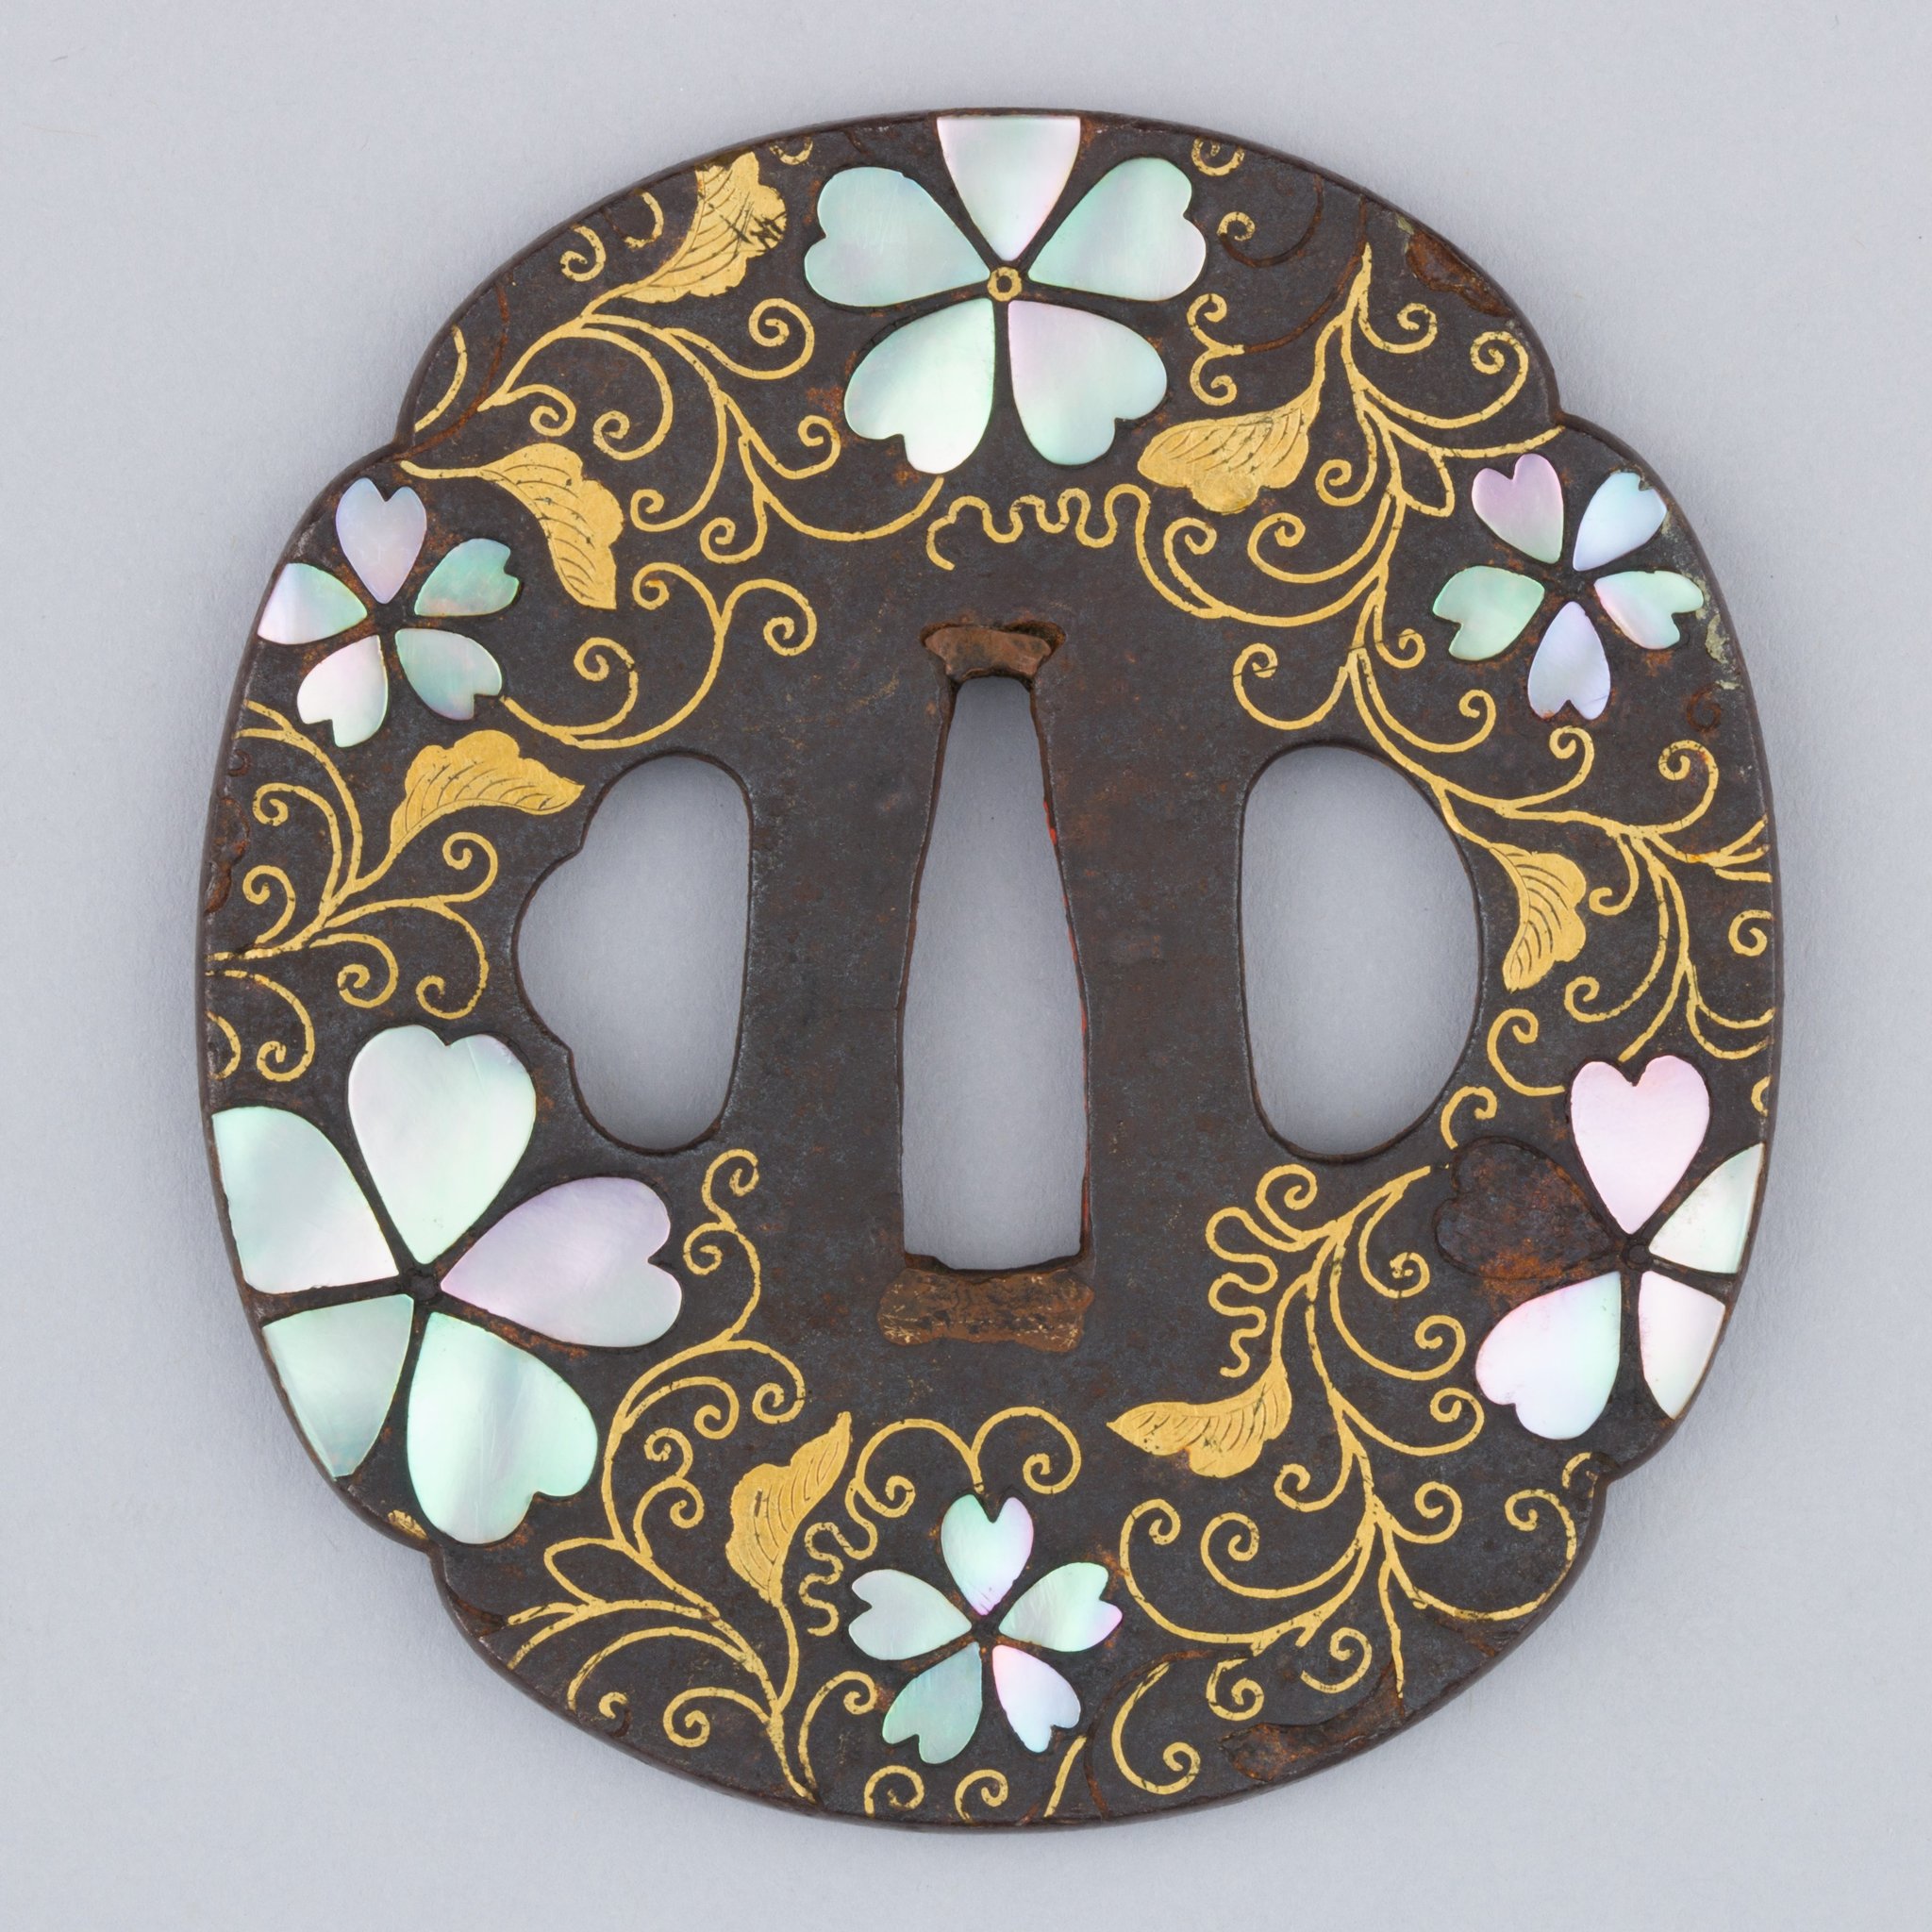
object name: sword guard tsuba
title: Sword Guard (Tsuba)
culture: japanese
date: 1615-1868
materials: copper, gold, iron, mother of pearl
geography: japan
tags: flowers